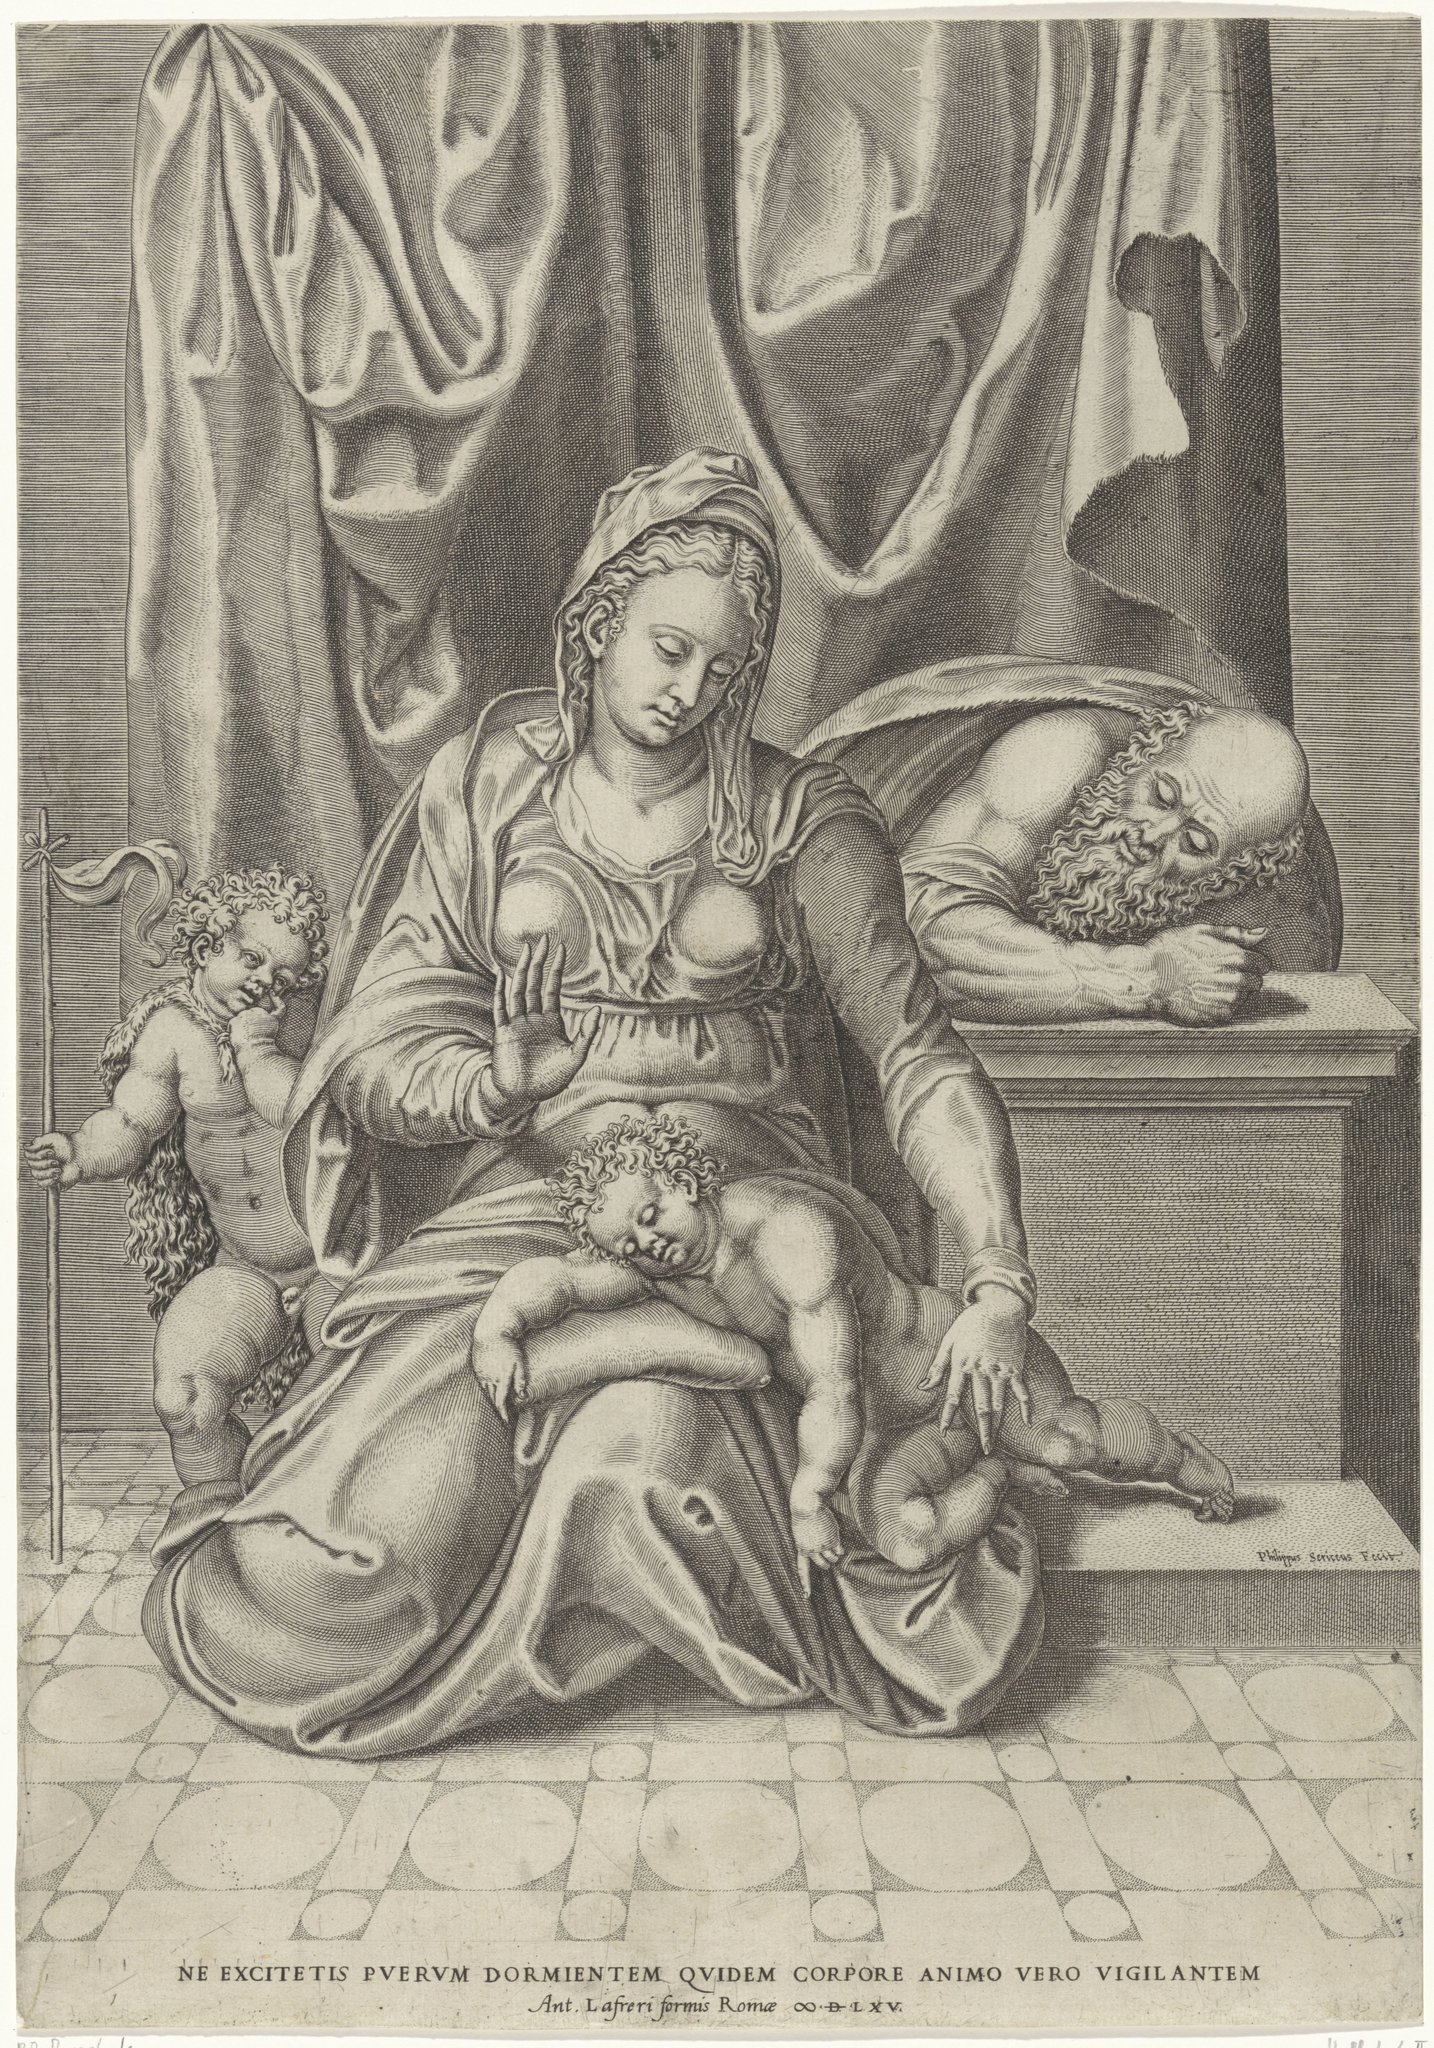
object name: print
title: Heilige Familie met Johannes de Doper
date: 1565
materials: paper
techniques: engraving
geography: rome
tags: holy family with john the baptist (as child), christ-child sleeping ~ madonna-representations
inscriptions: collector's mark: Lugt 2228, collector's mark: Lugt 3791, inscription: ‘NE EXCITETIS DORMIENTEM QUIDEM CORPORE ANIMO VERO VIGILANTEM’, signature and date: ‘rechts, op de sokkel gesigneerd: Philippus Sericeus fecit; m.o. Ant. Lafrery formis Romae 1565’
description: Het Christuskind ligt te slapen op de schoot van Maria. Links staat Johannes de Doper in een mantel van kameelhaar en met kruisvaan. Rechts Jozef, leunend op een stenen sokkel. Een draperie als achtergrond.